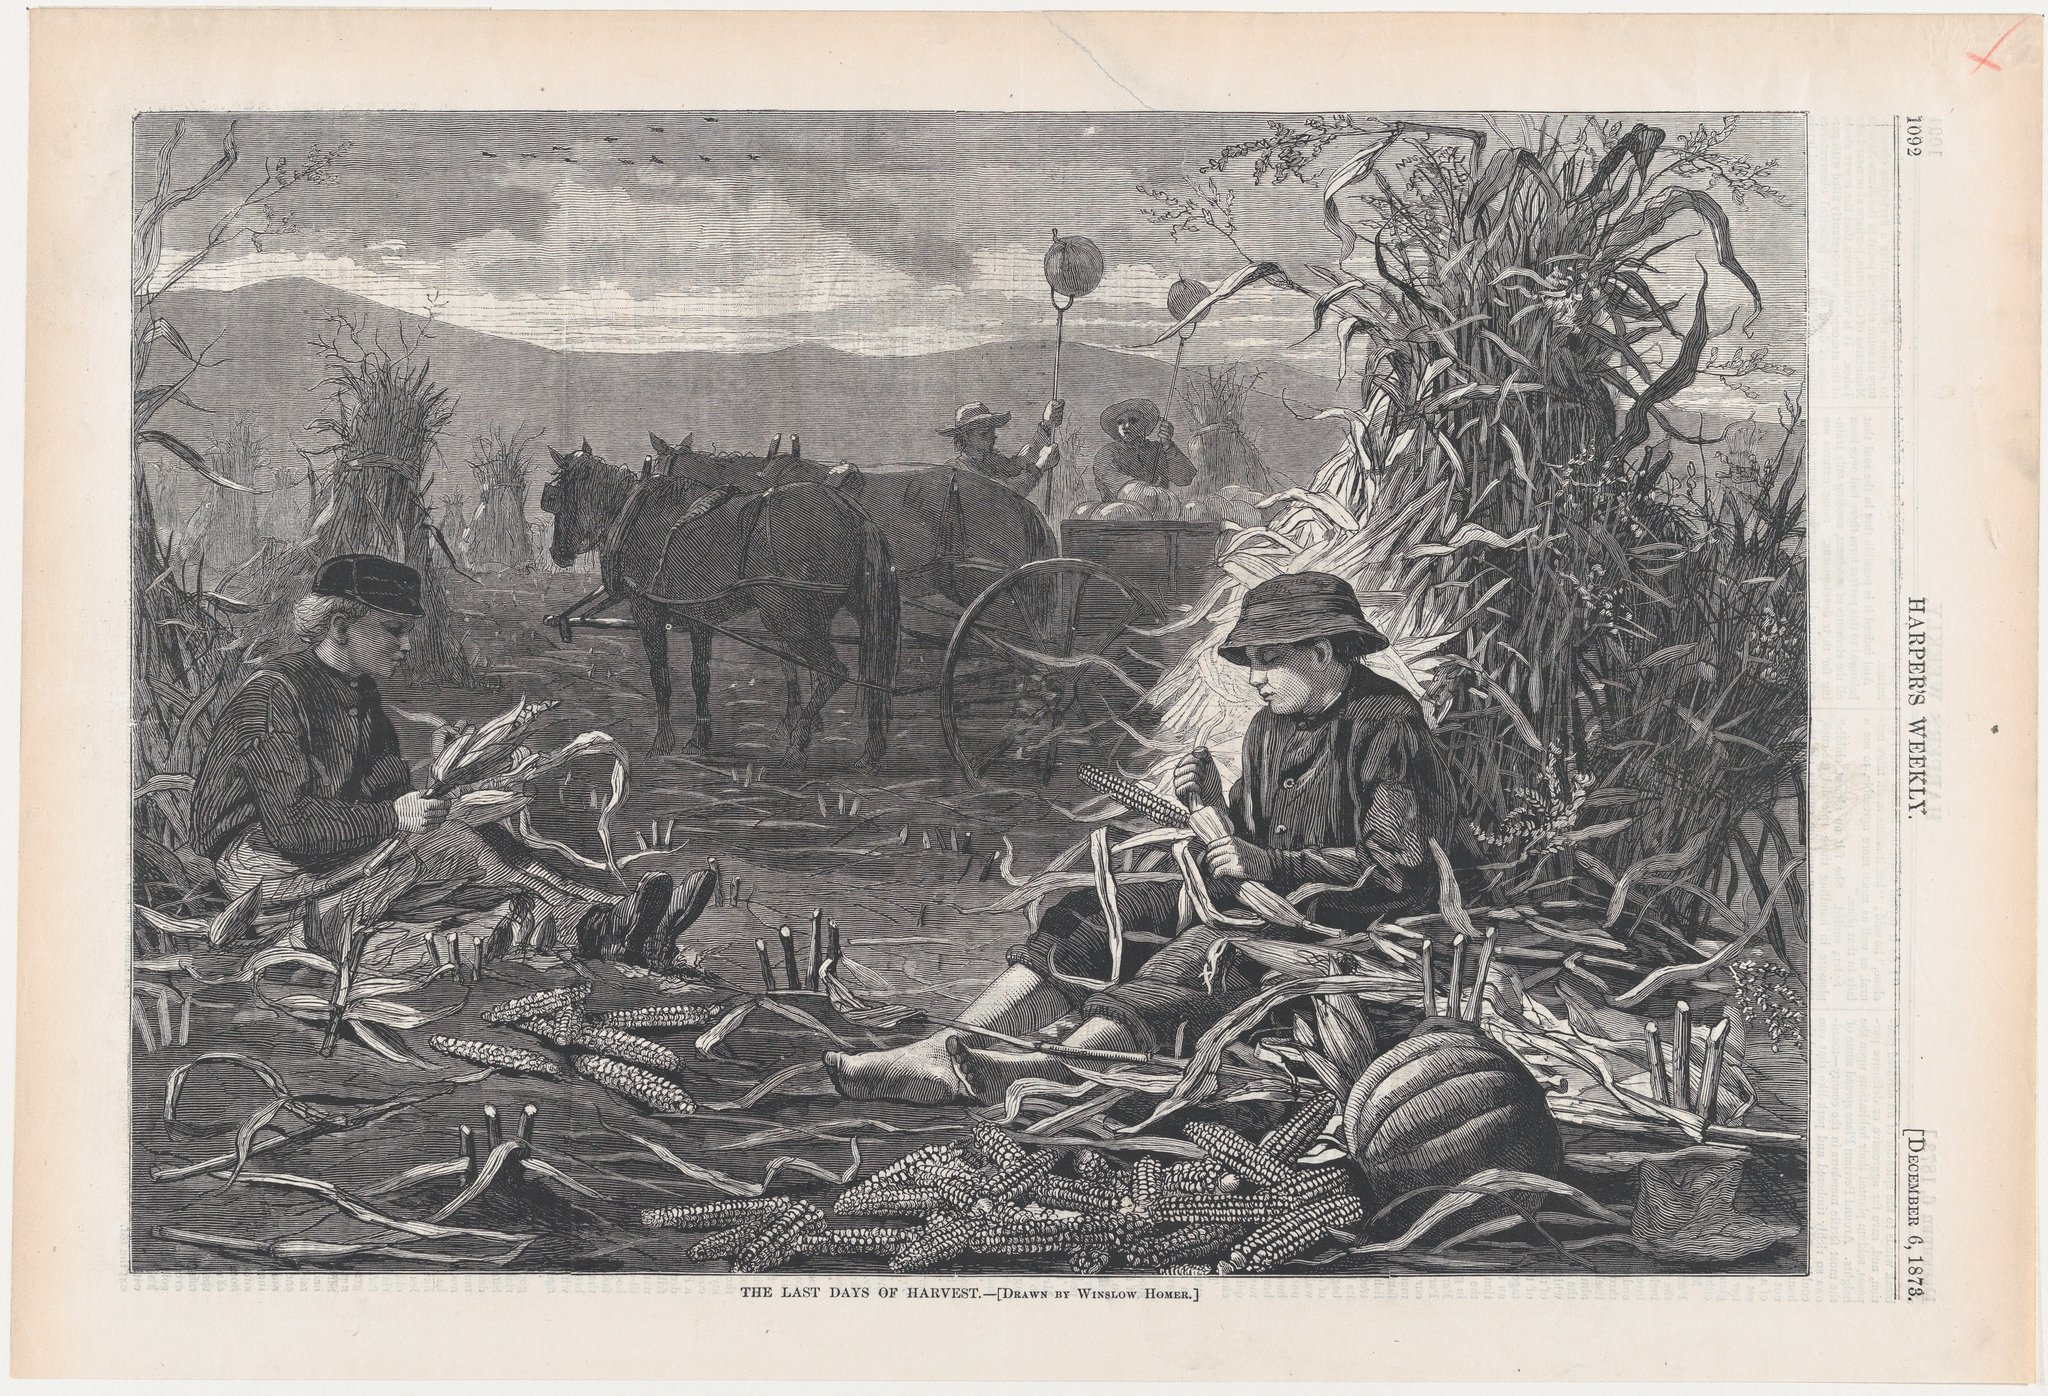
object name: print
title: The Last Days of Harvest (from "Harper's Weekly," Vol. XVII)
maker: winslow homer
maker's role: artist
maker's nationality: american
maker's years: 1836-1910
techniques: engraving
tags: men,agriculture,carriages